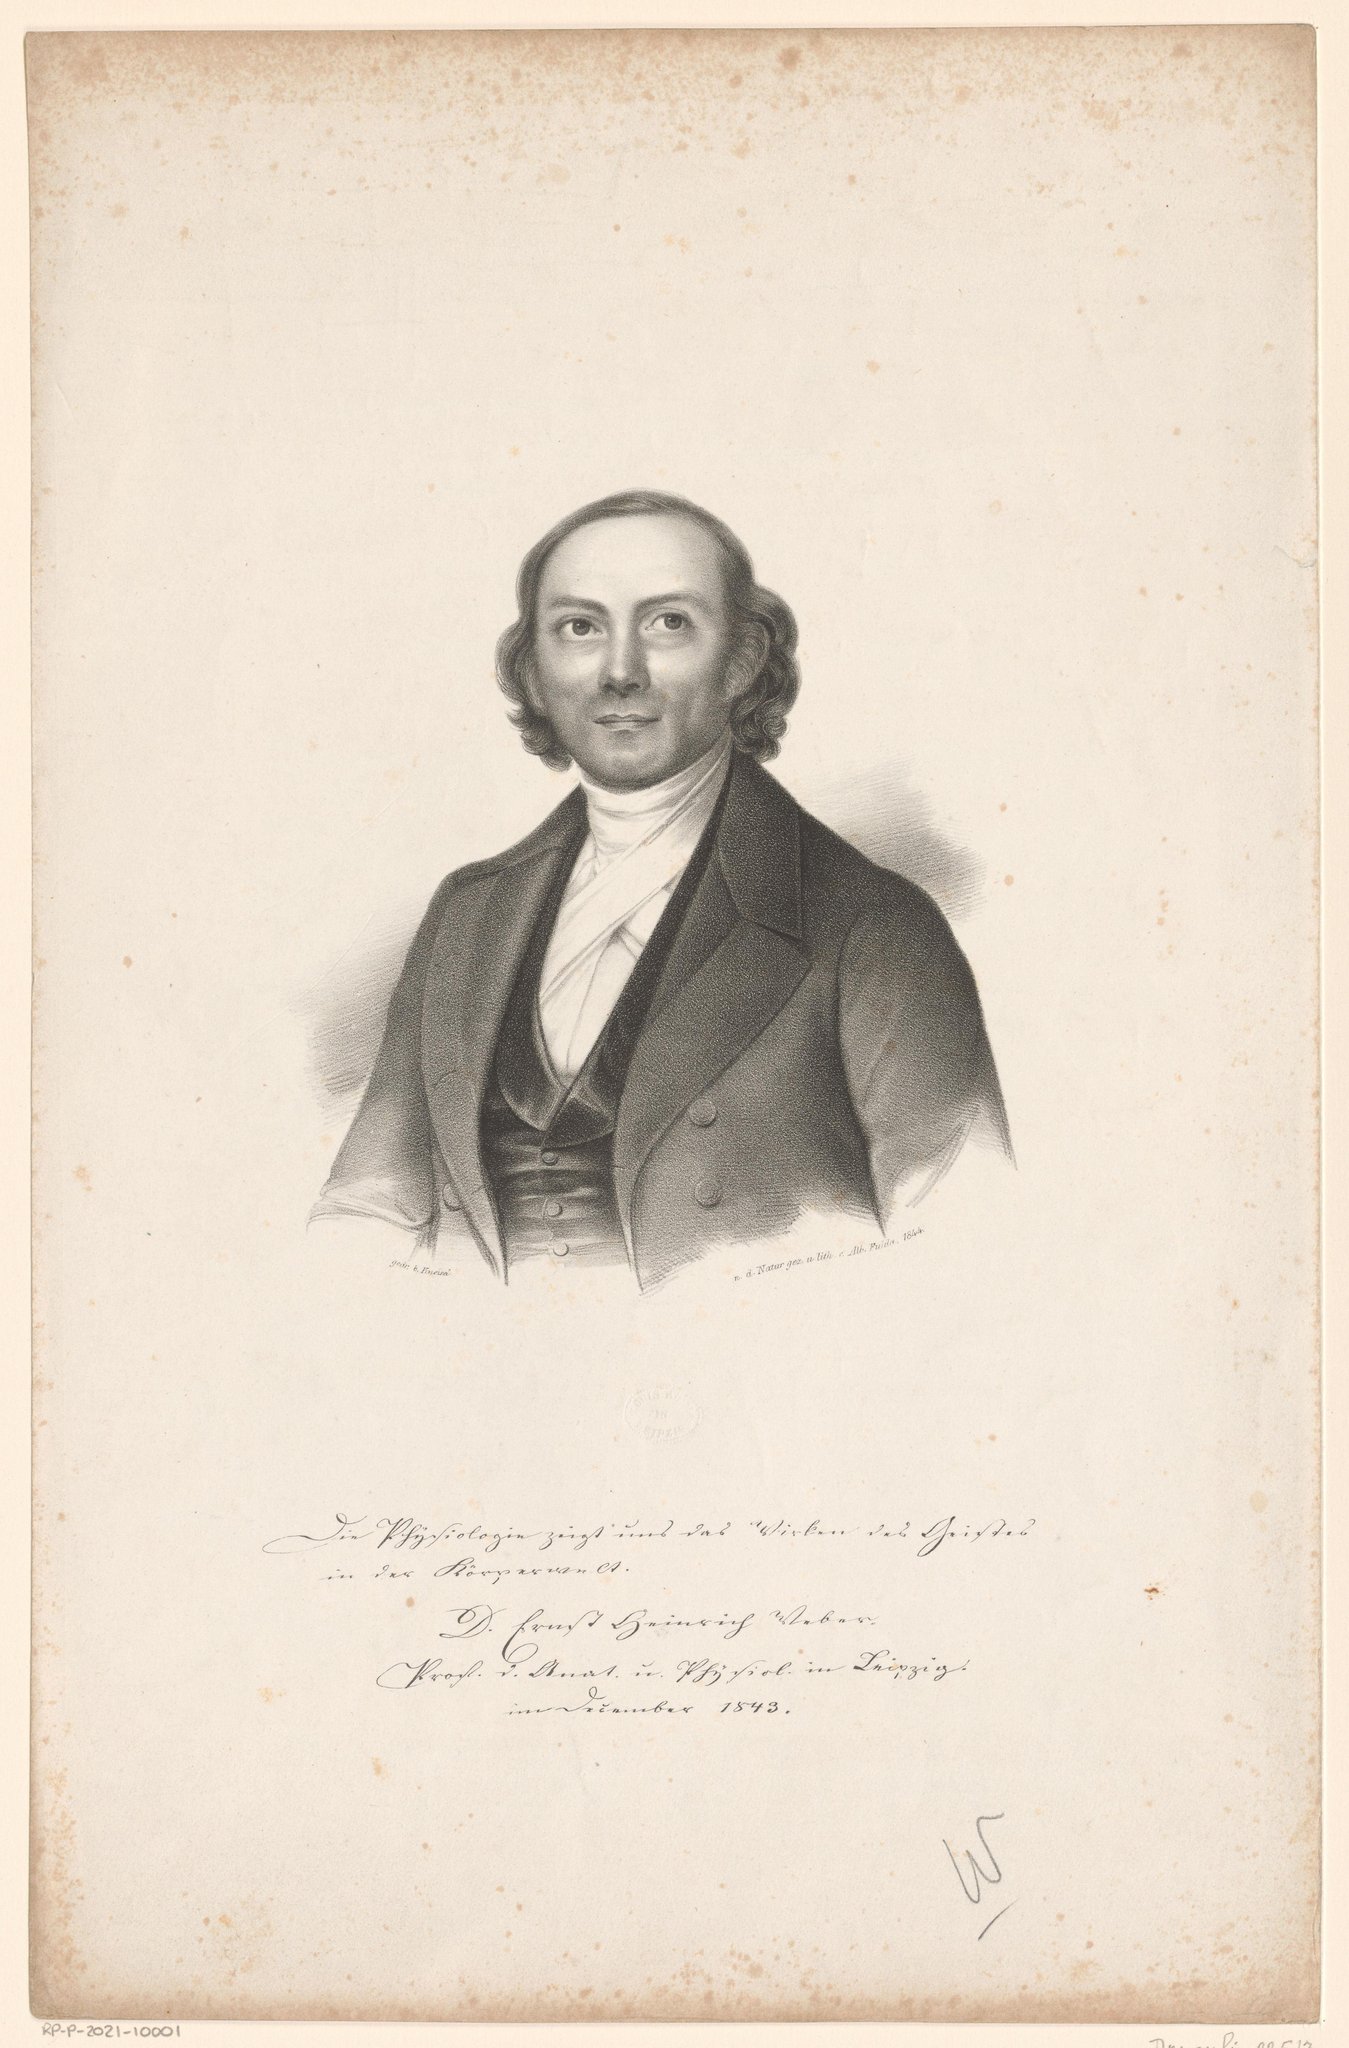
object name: print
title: Portret van Ernst Heinrich Weber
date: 1844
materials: paper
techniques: lithograph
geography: leipzig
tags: adult man, historical persons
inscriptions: collector's mark: Lugt 2228, check stamp: ‘Louis Rocca in Leipzig’